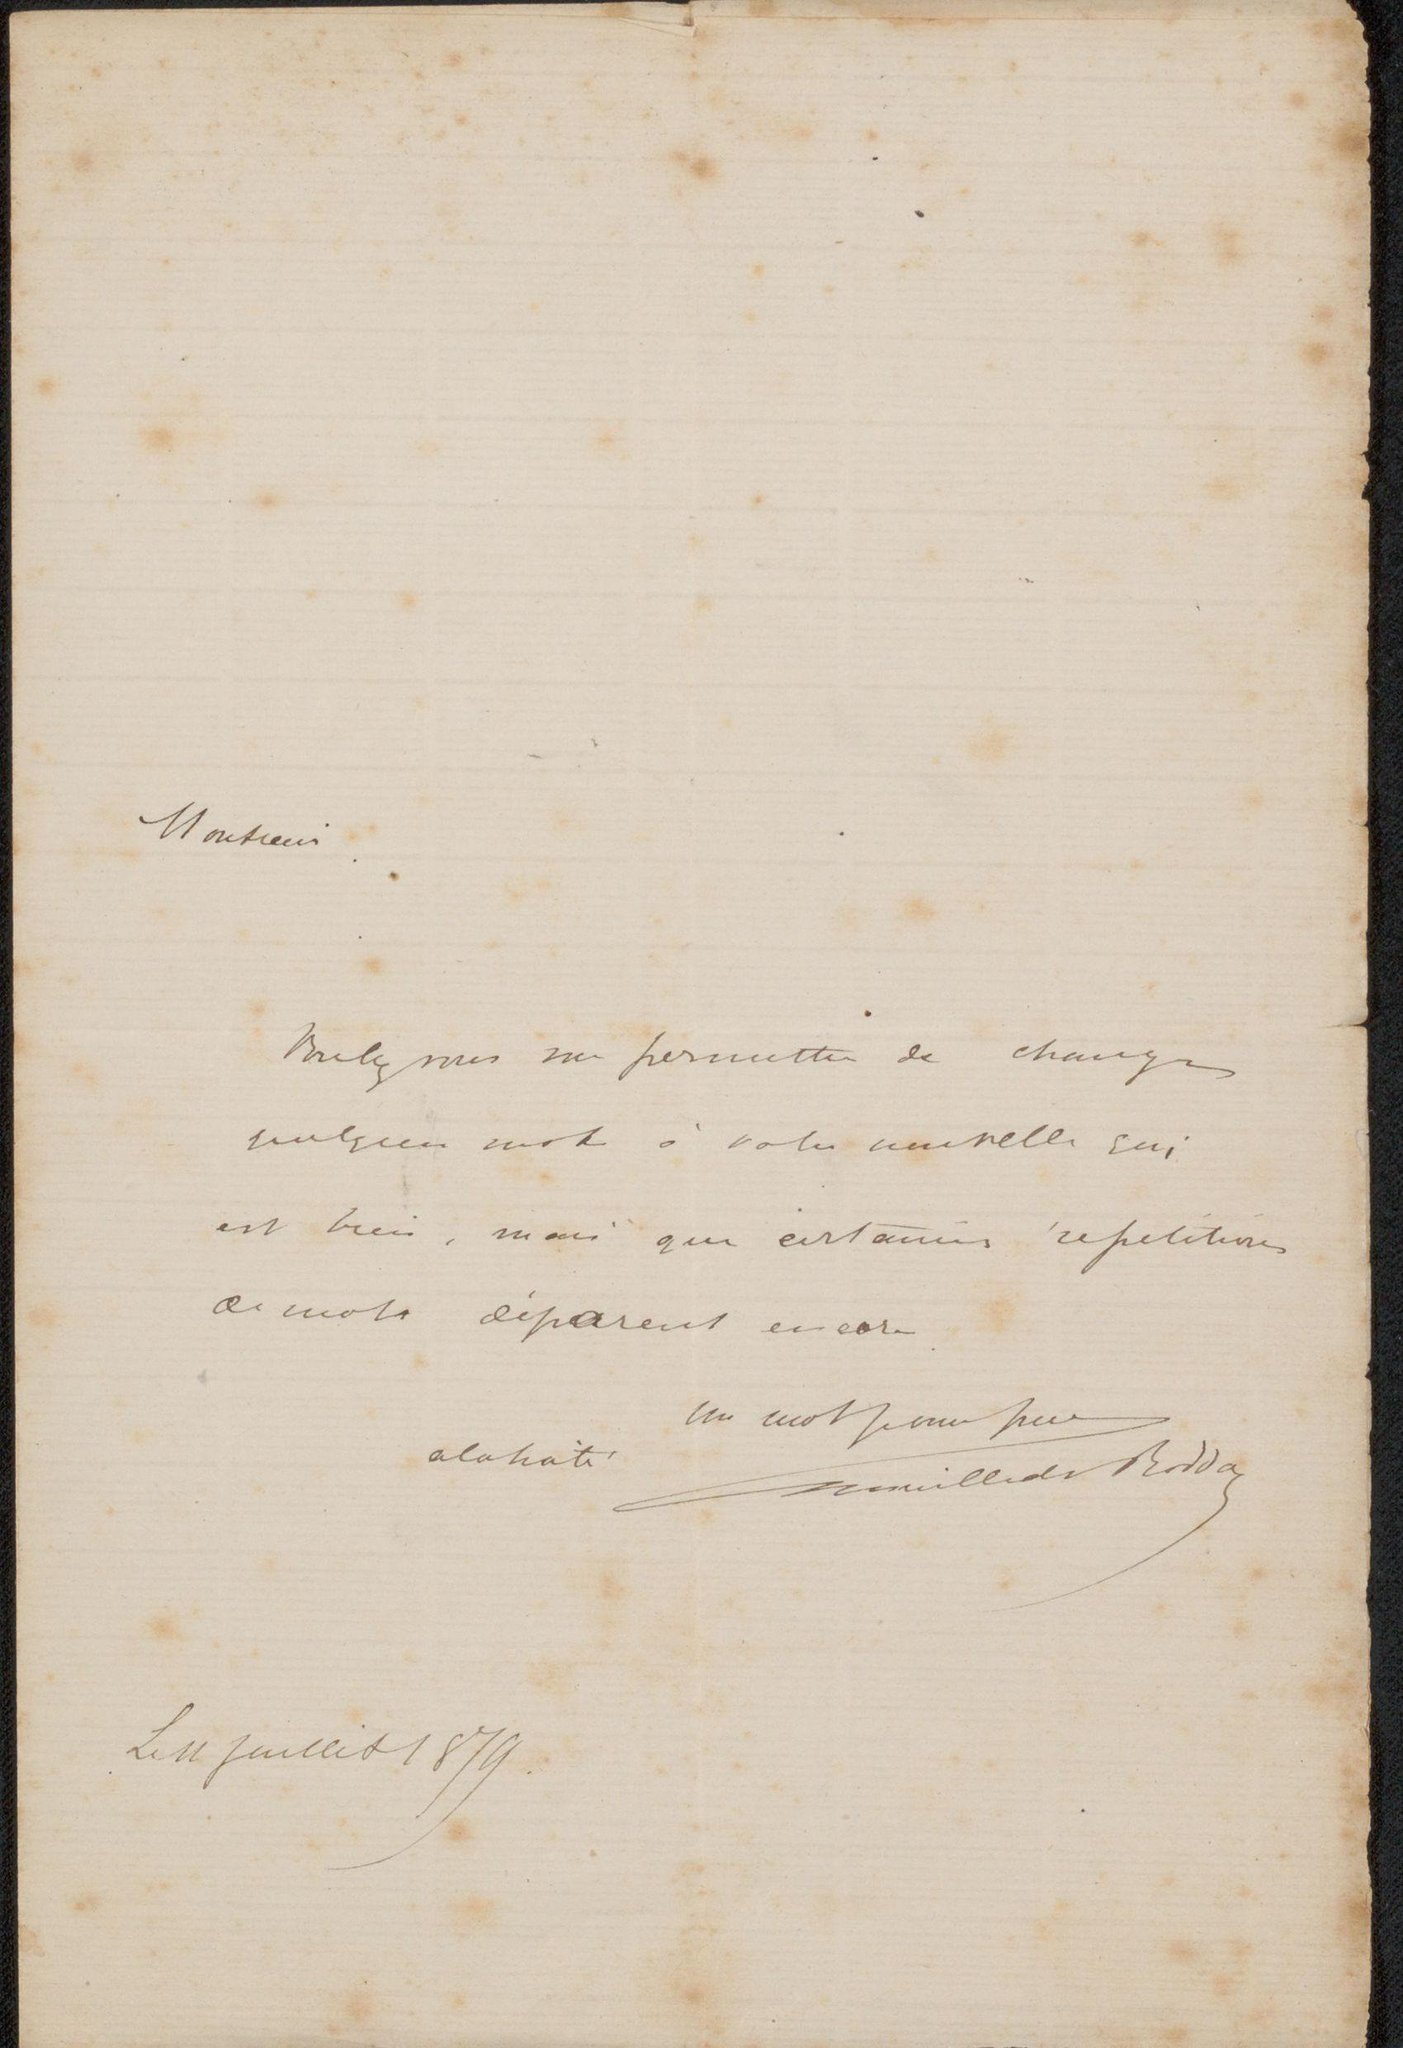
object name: letter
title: Brief aan Philip Zilcken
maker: camille de rodder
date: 1879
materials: ink, paper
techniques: pen, writing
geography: brussels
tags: the hague, painter, draughtsman, philip zilcken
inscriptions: collector's mark: ‘RPK’